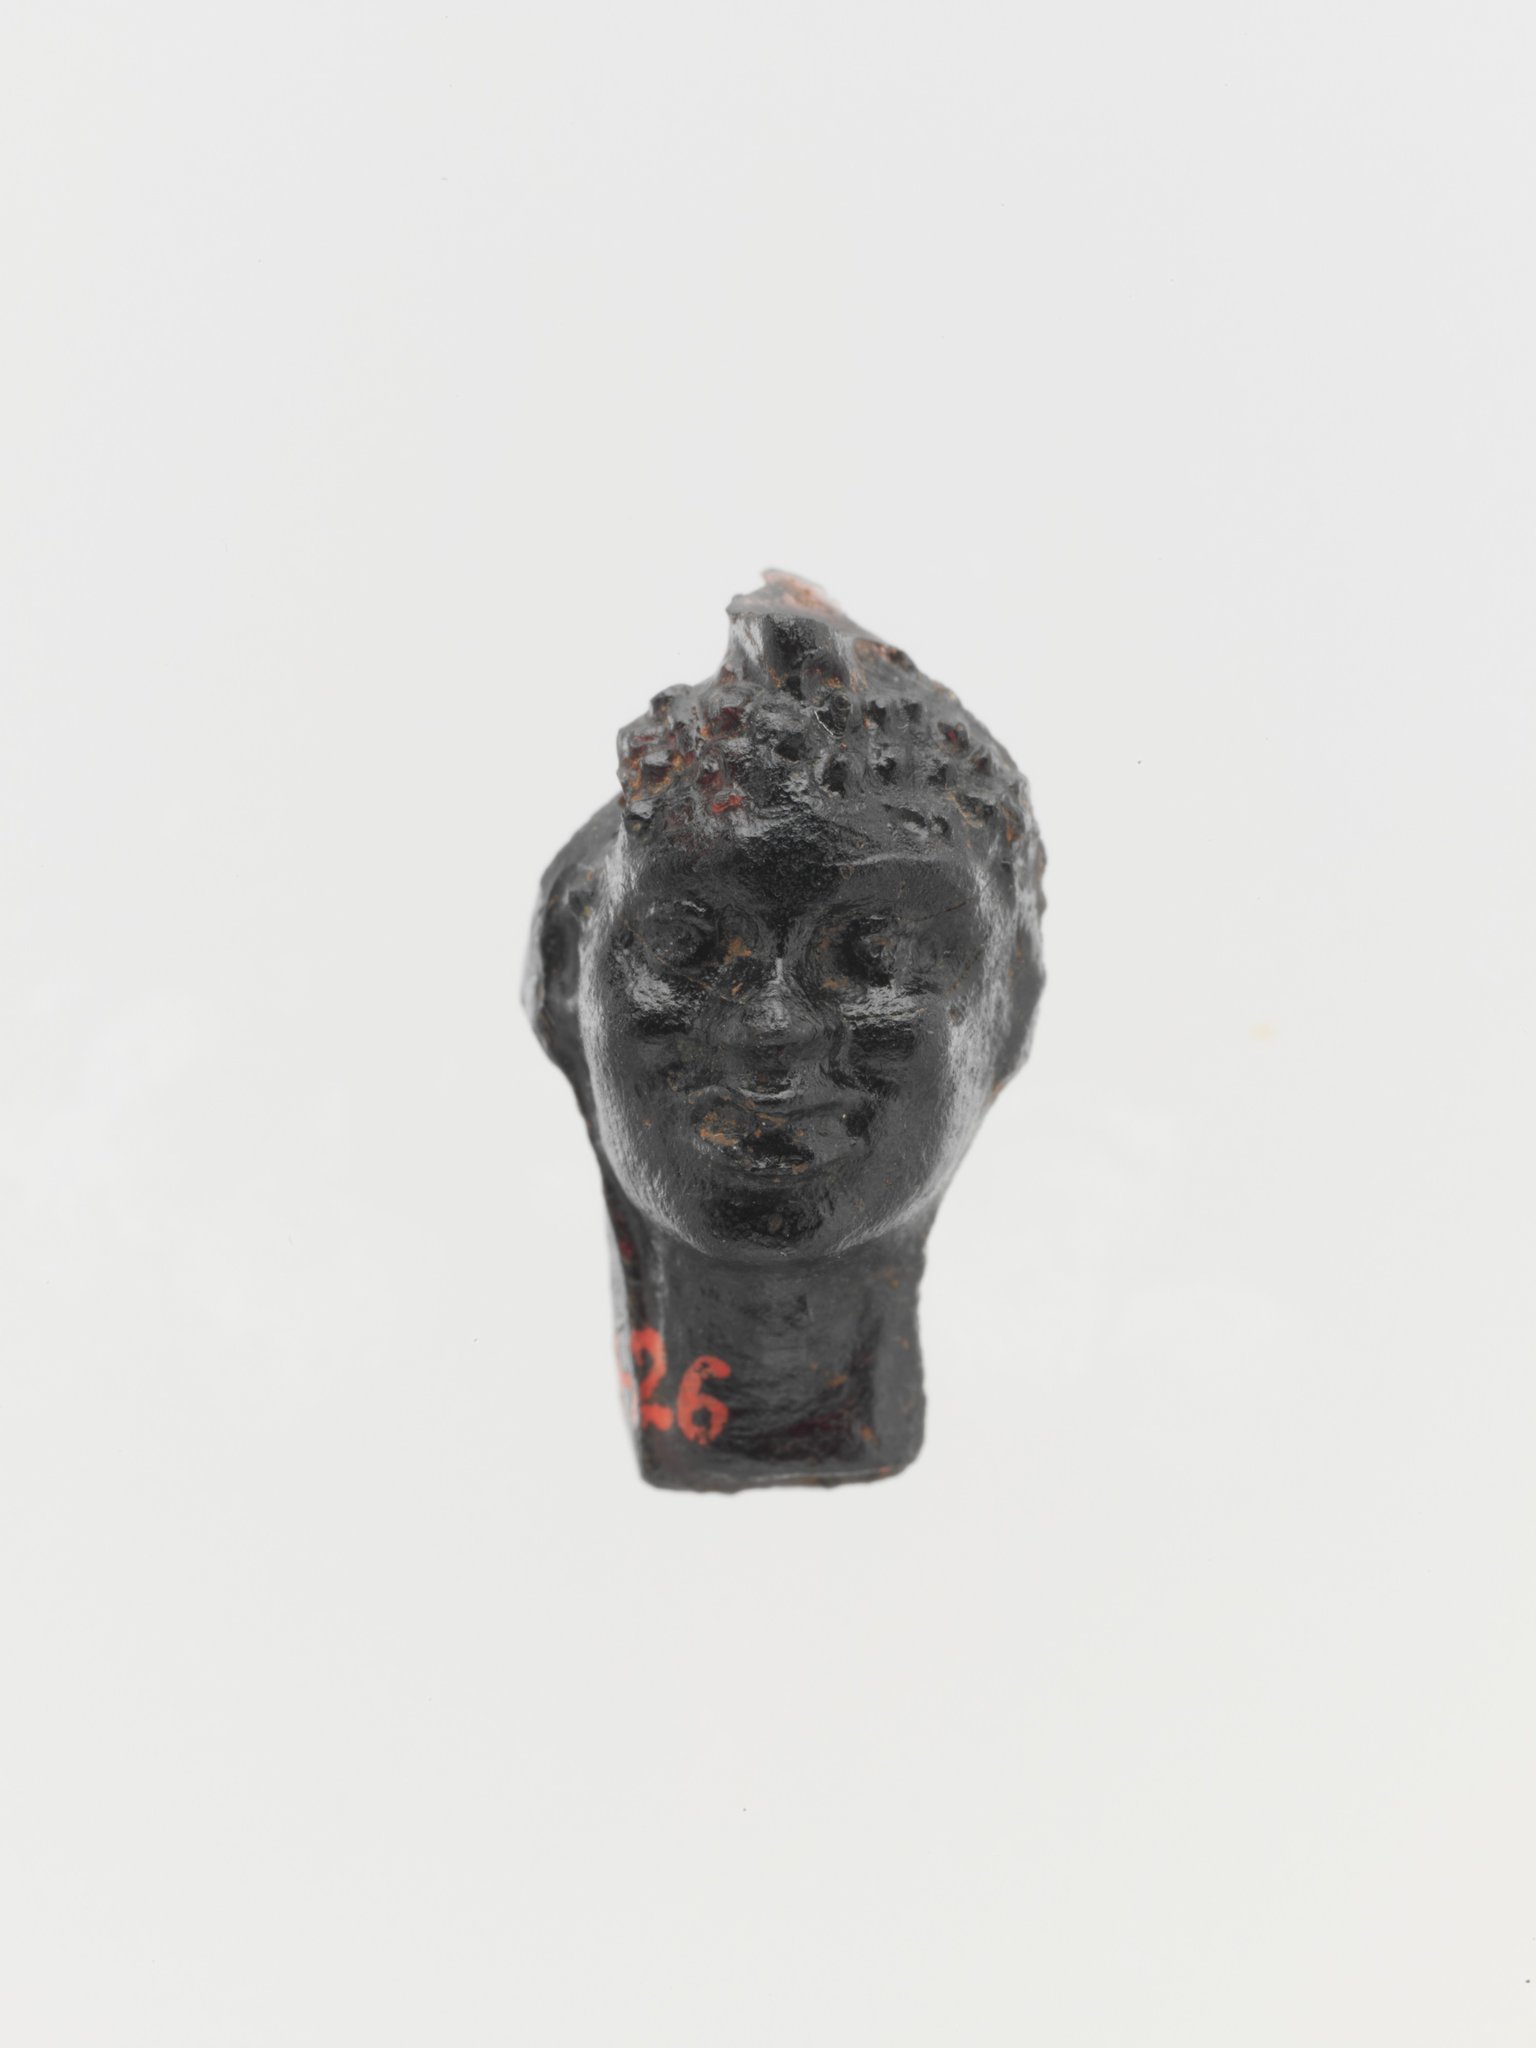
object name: head pendant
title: Glass pendant in the shape of a Black African’s head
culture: greek, eastern mediterranean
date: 134-1 BCE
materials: glass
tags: heads,women